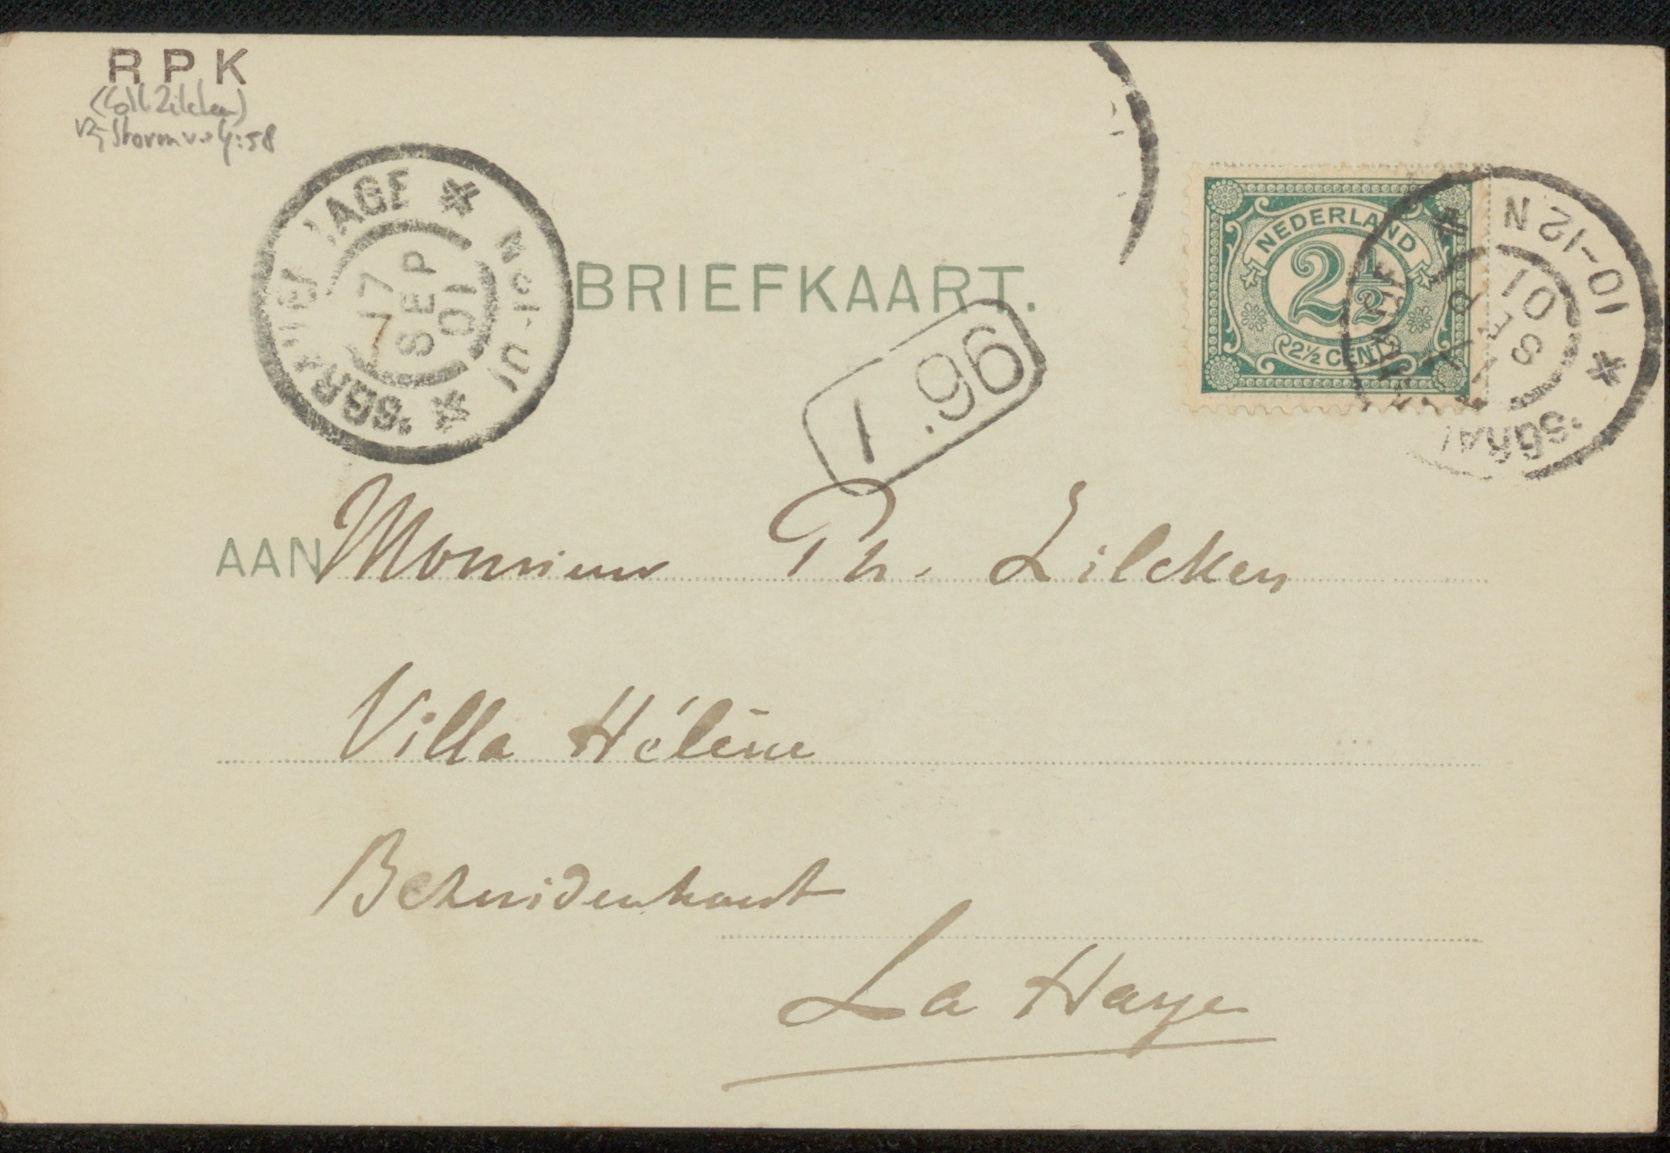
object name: postcard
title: Briefkaart aan Philip Zilcken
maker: carel nicolaas storm van s-gravesande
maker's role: draughtsman, print maker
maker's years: 1841-1924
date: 1901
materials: cardboard, ink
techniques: pen, writing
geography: the hague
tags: the hague, painter, draughtsman, philip zilcken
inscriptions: collector's mark: ‘RPK’